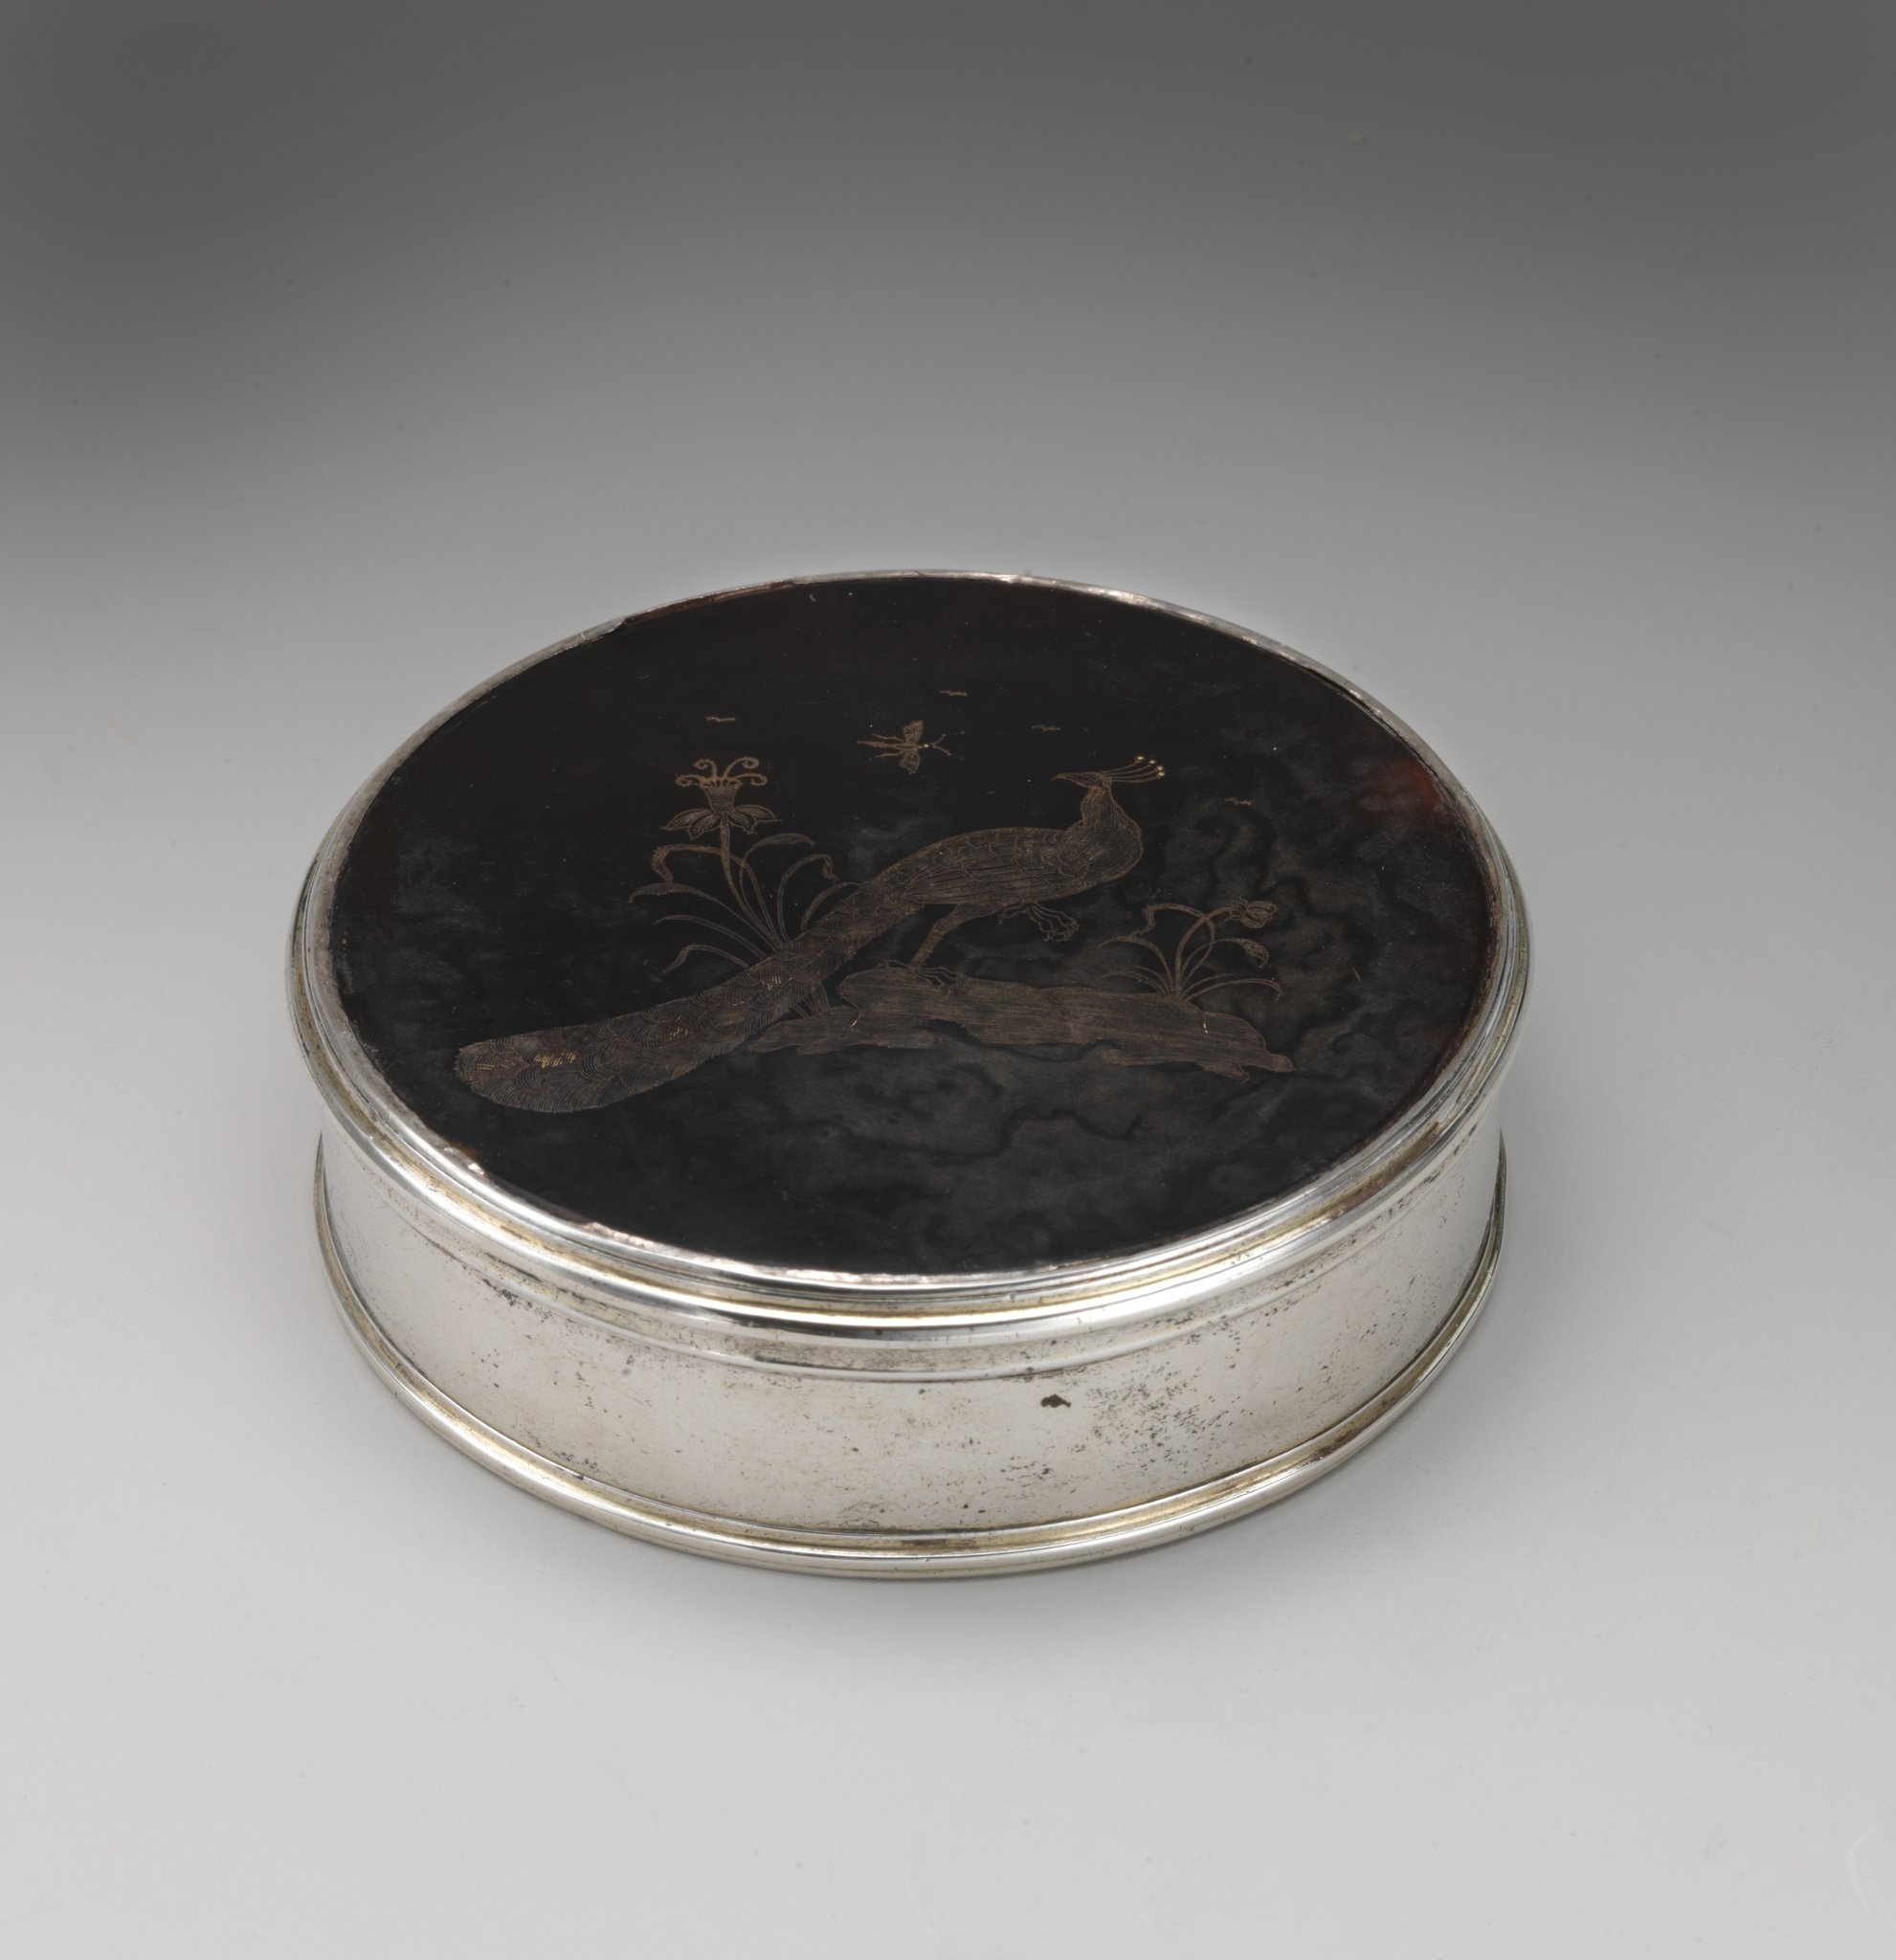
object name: box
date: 1801-1833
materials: gold, silver, shell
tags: peacocks